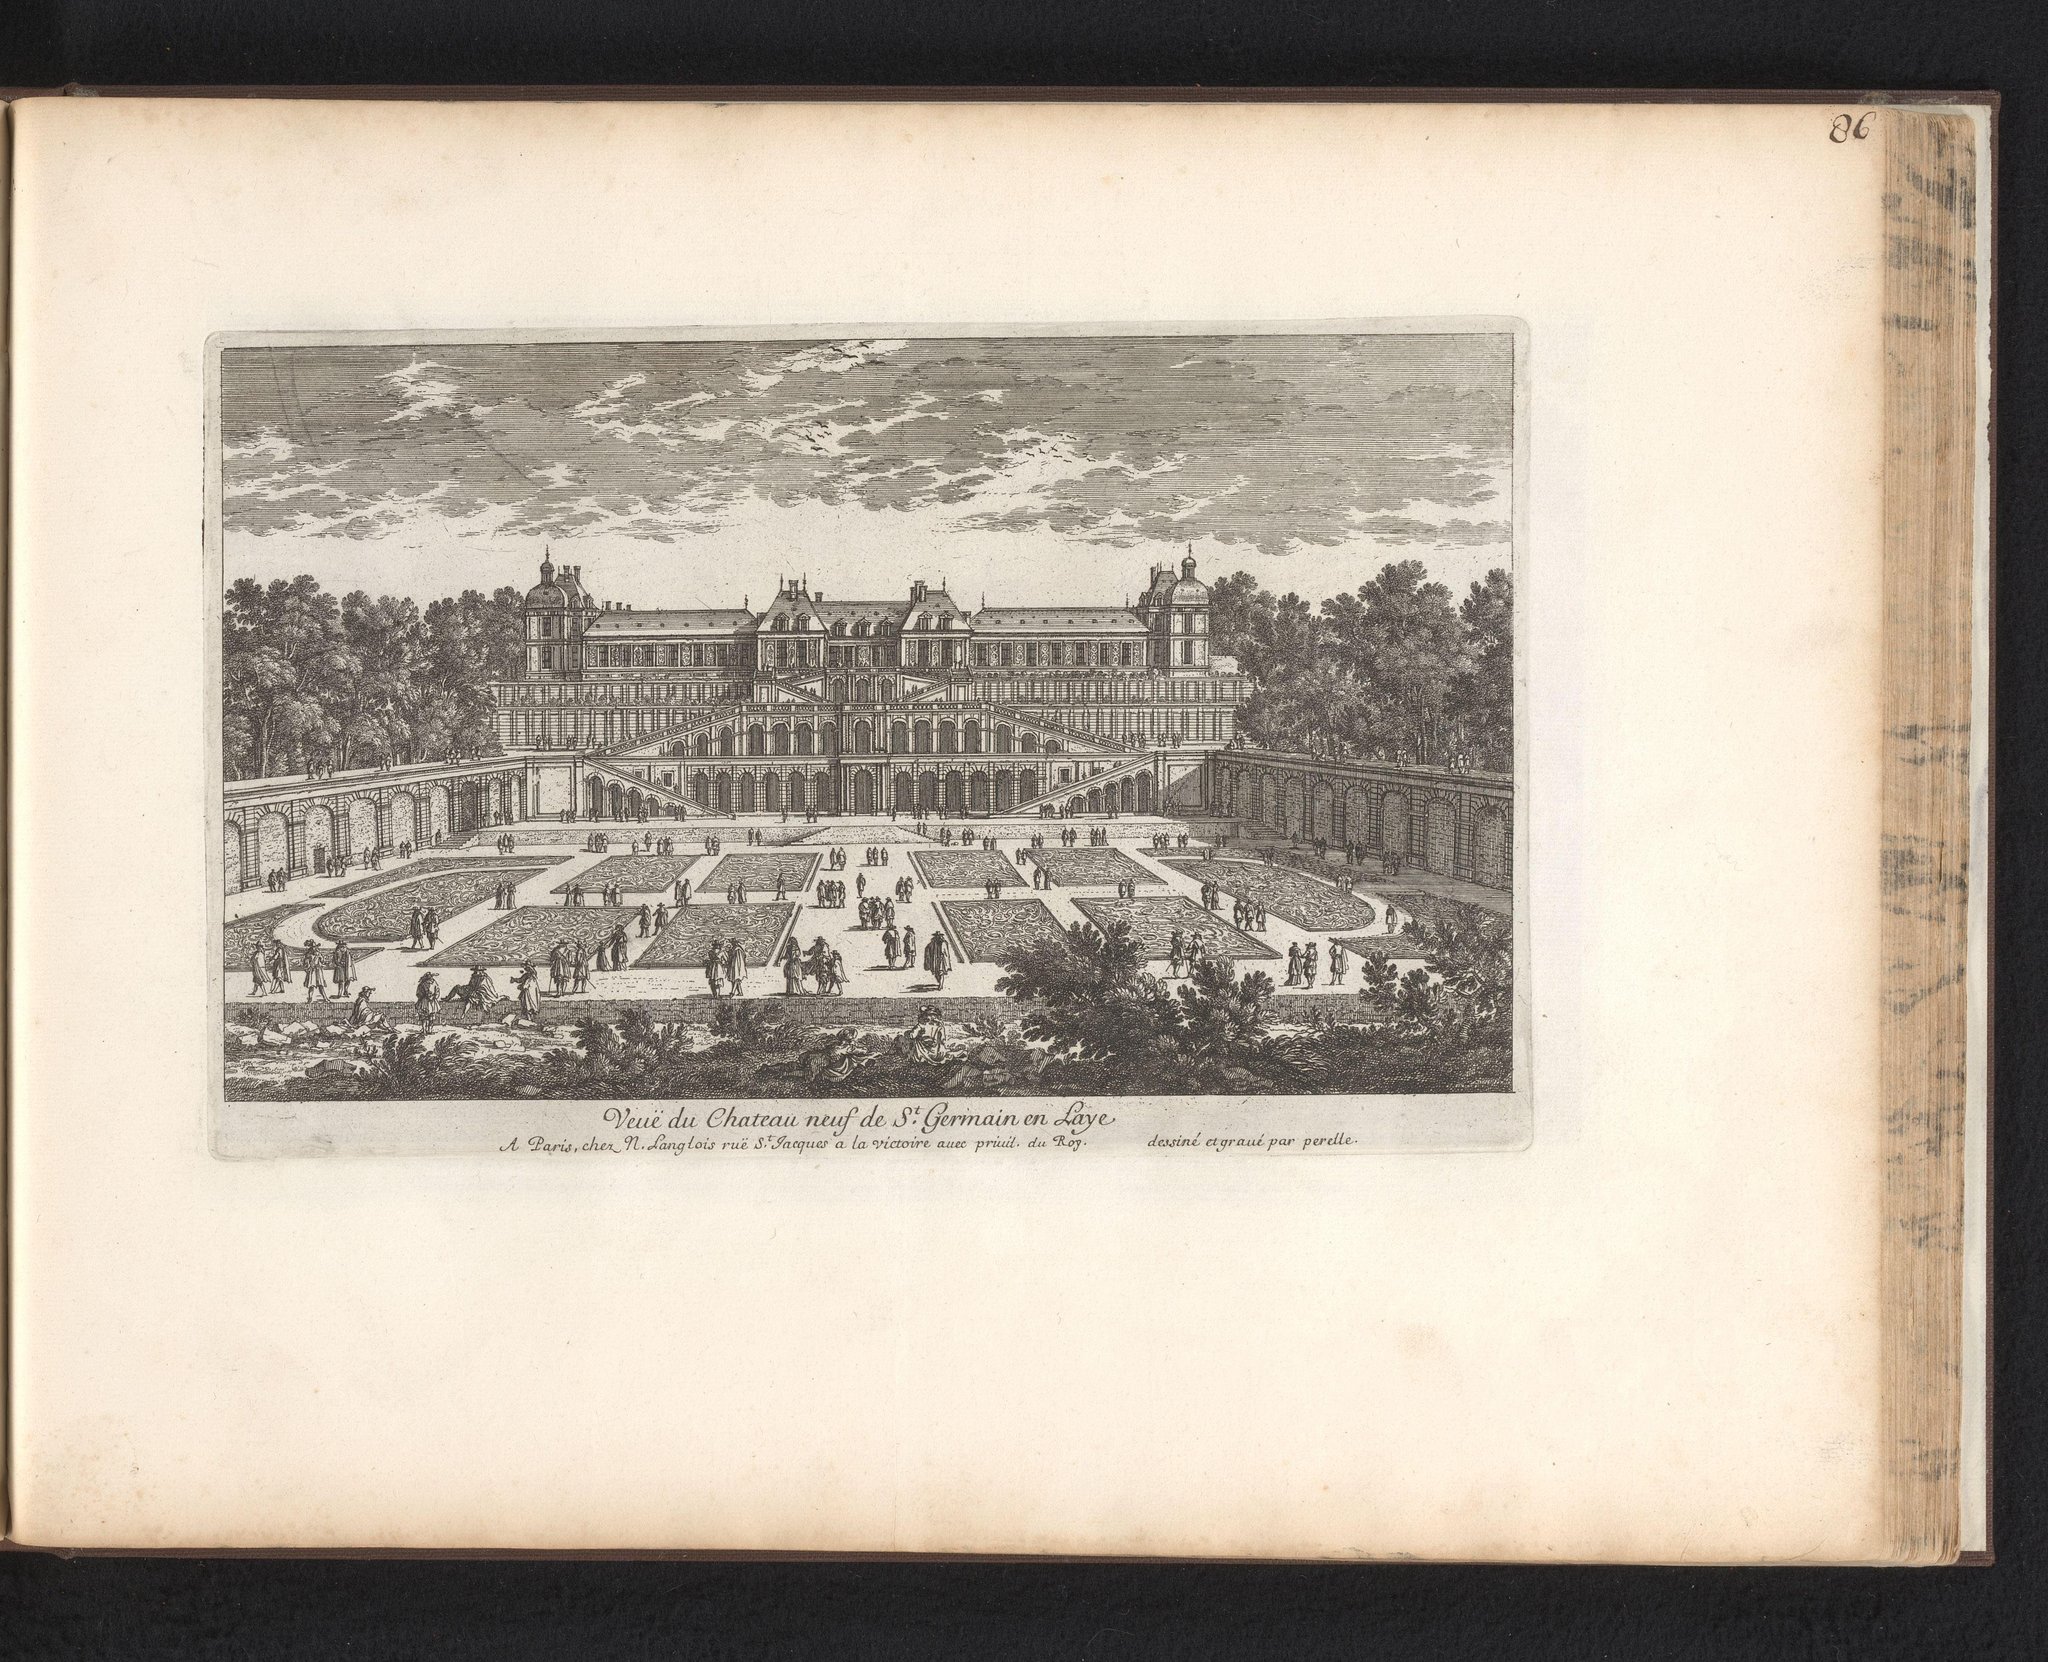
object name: print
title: Veuë du Chateau neuf de St. Germain en Laye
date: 1620-1695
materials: paper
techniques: etching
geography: paris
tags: french or architectonic garden; formal garden, landscape with tower or castle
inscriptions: collector's mark: Lugt 2228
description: Prenten met het signatuur 'Perelle' kunnen zowel door vader Gabriel als door zonen Nicolas en Adam gemaakt zijn. De uitgevers vader en zoon Nicolas Langlois worden allebei vermeld als N. Langlois op hetzelfde adres.